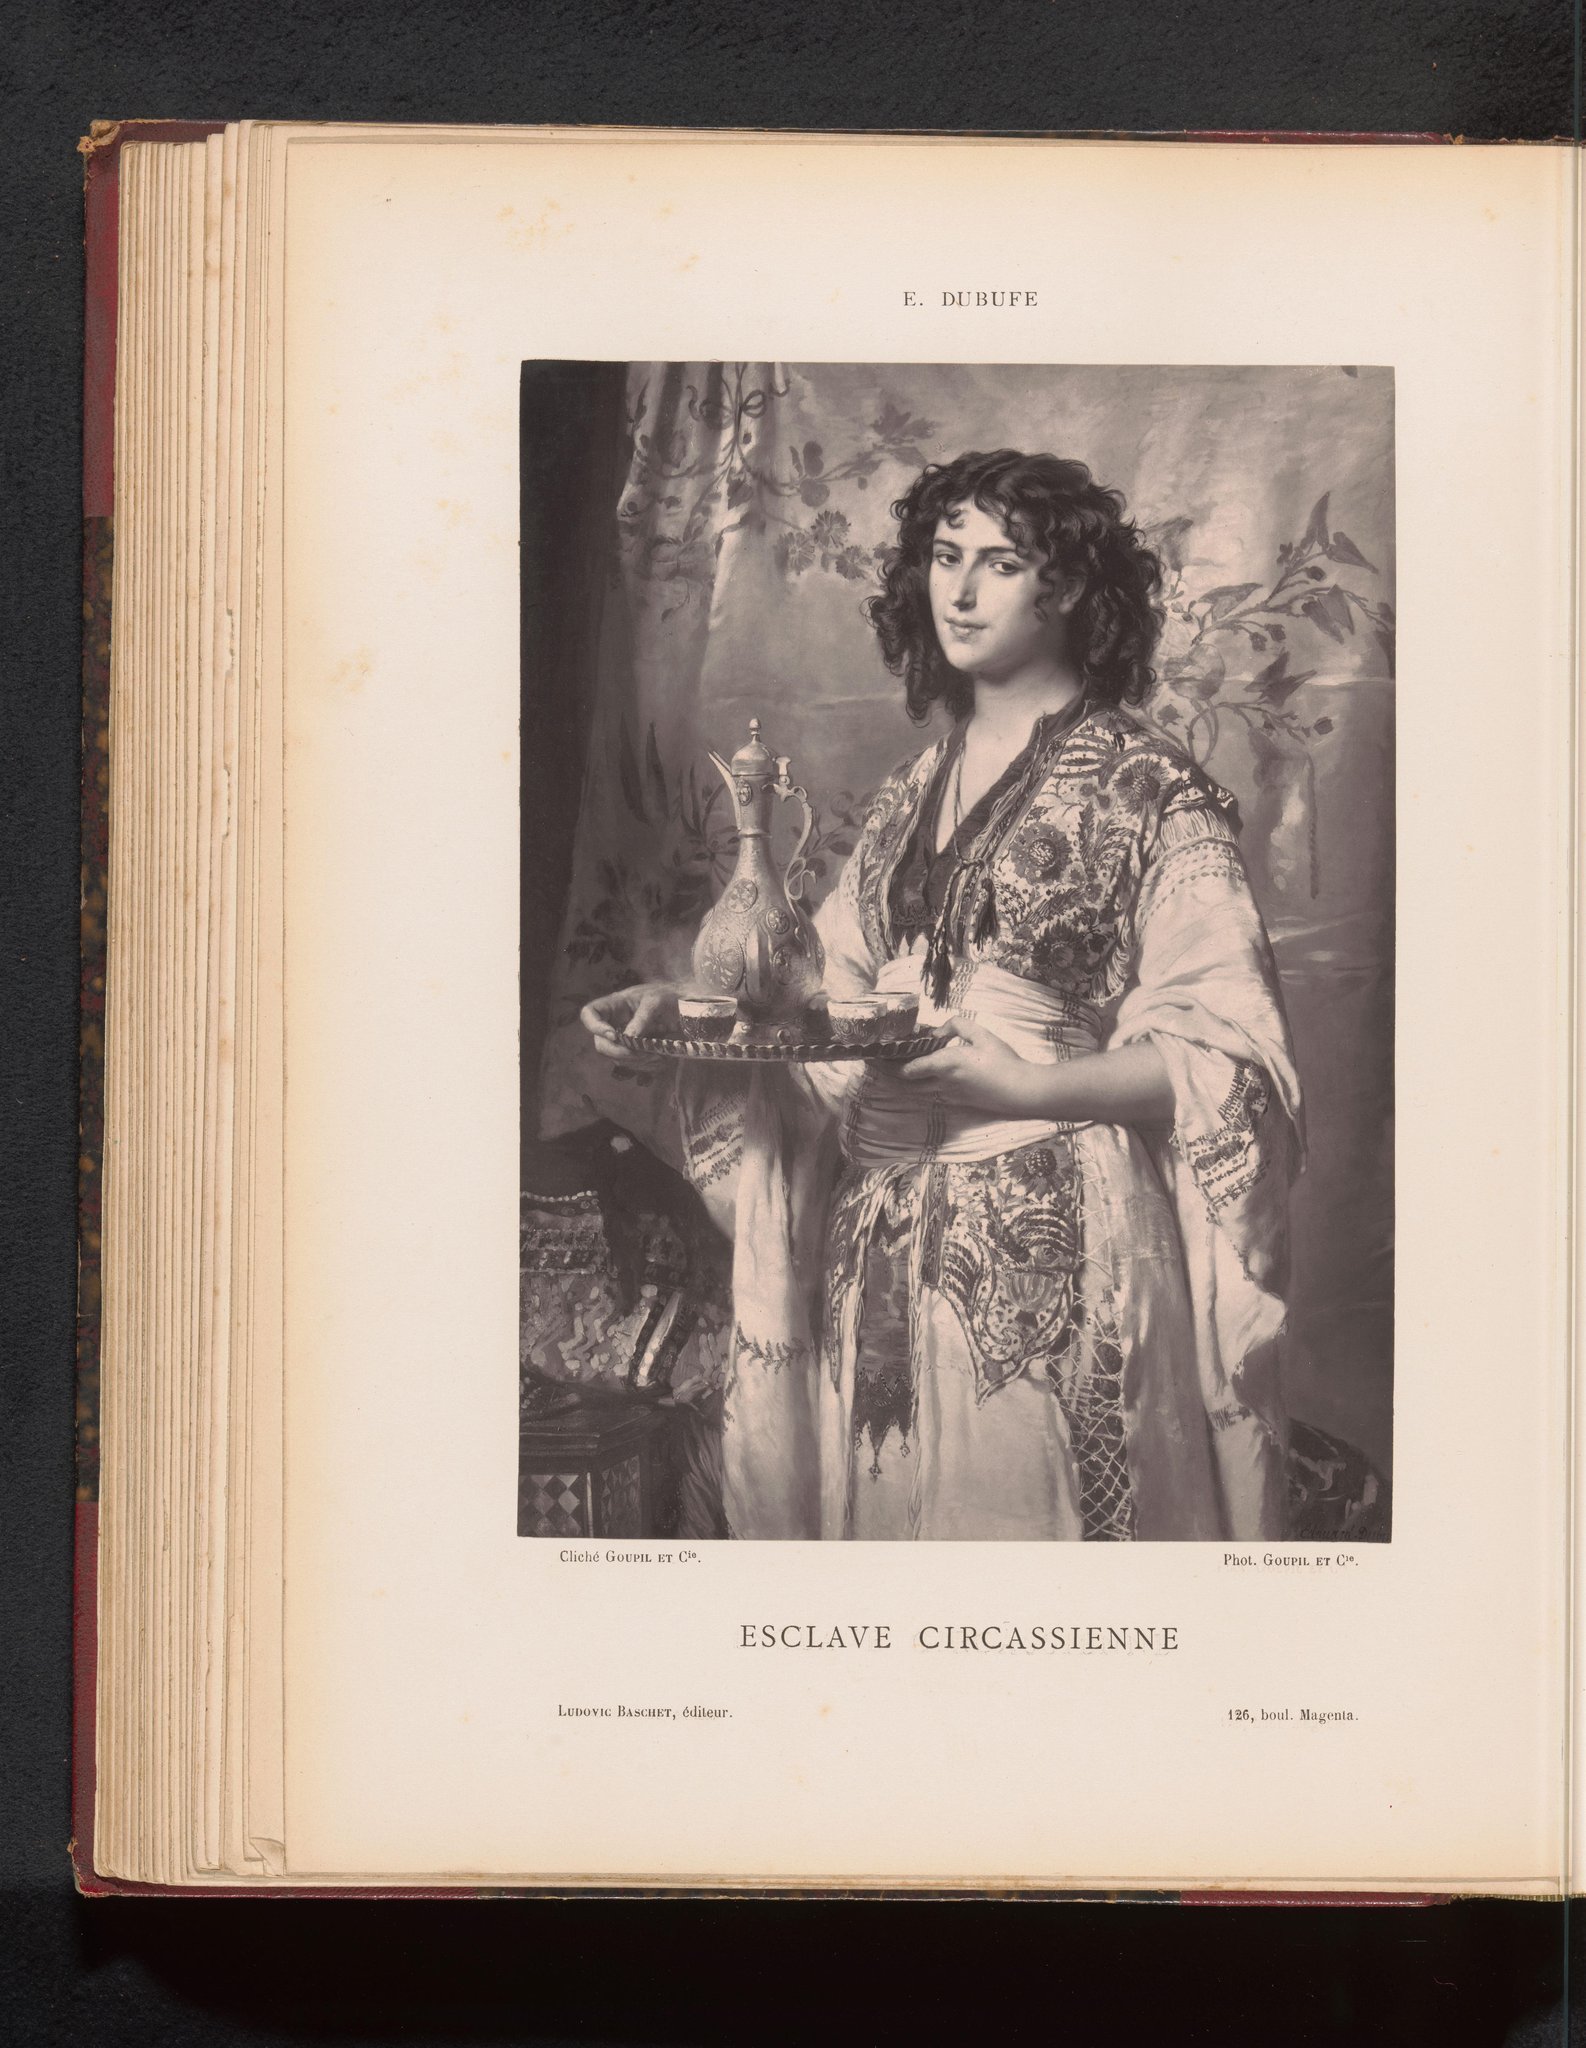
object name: photomechanical print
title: Esclave Circassienne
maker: edouard dubufe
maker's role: painter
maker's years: 1820-1883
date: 1871-1876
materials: paper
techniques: woodburytype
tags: adult woman, painting, drawing and the graphic arts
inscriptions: inscription: ‘E. Dubufe/ Ludovic Baschet, éditeur/ 126, boul. Magenta.’